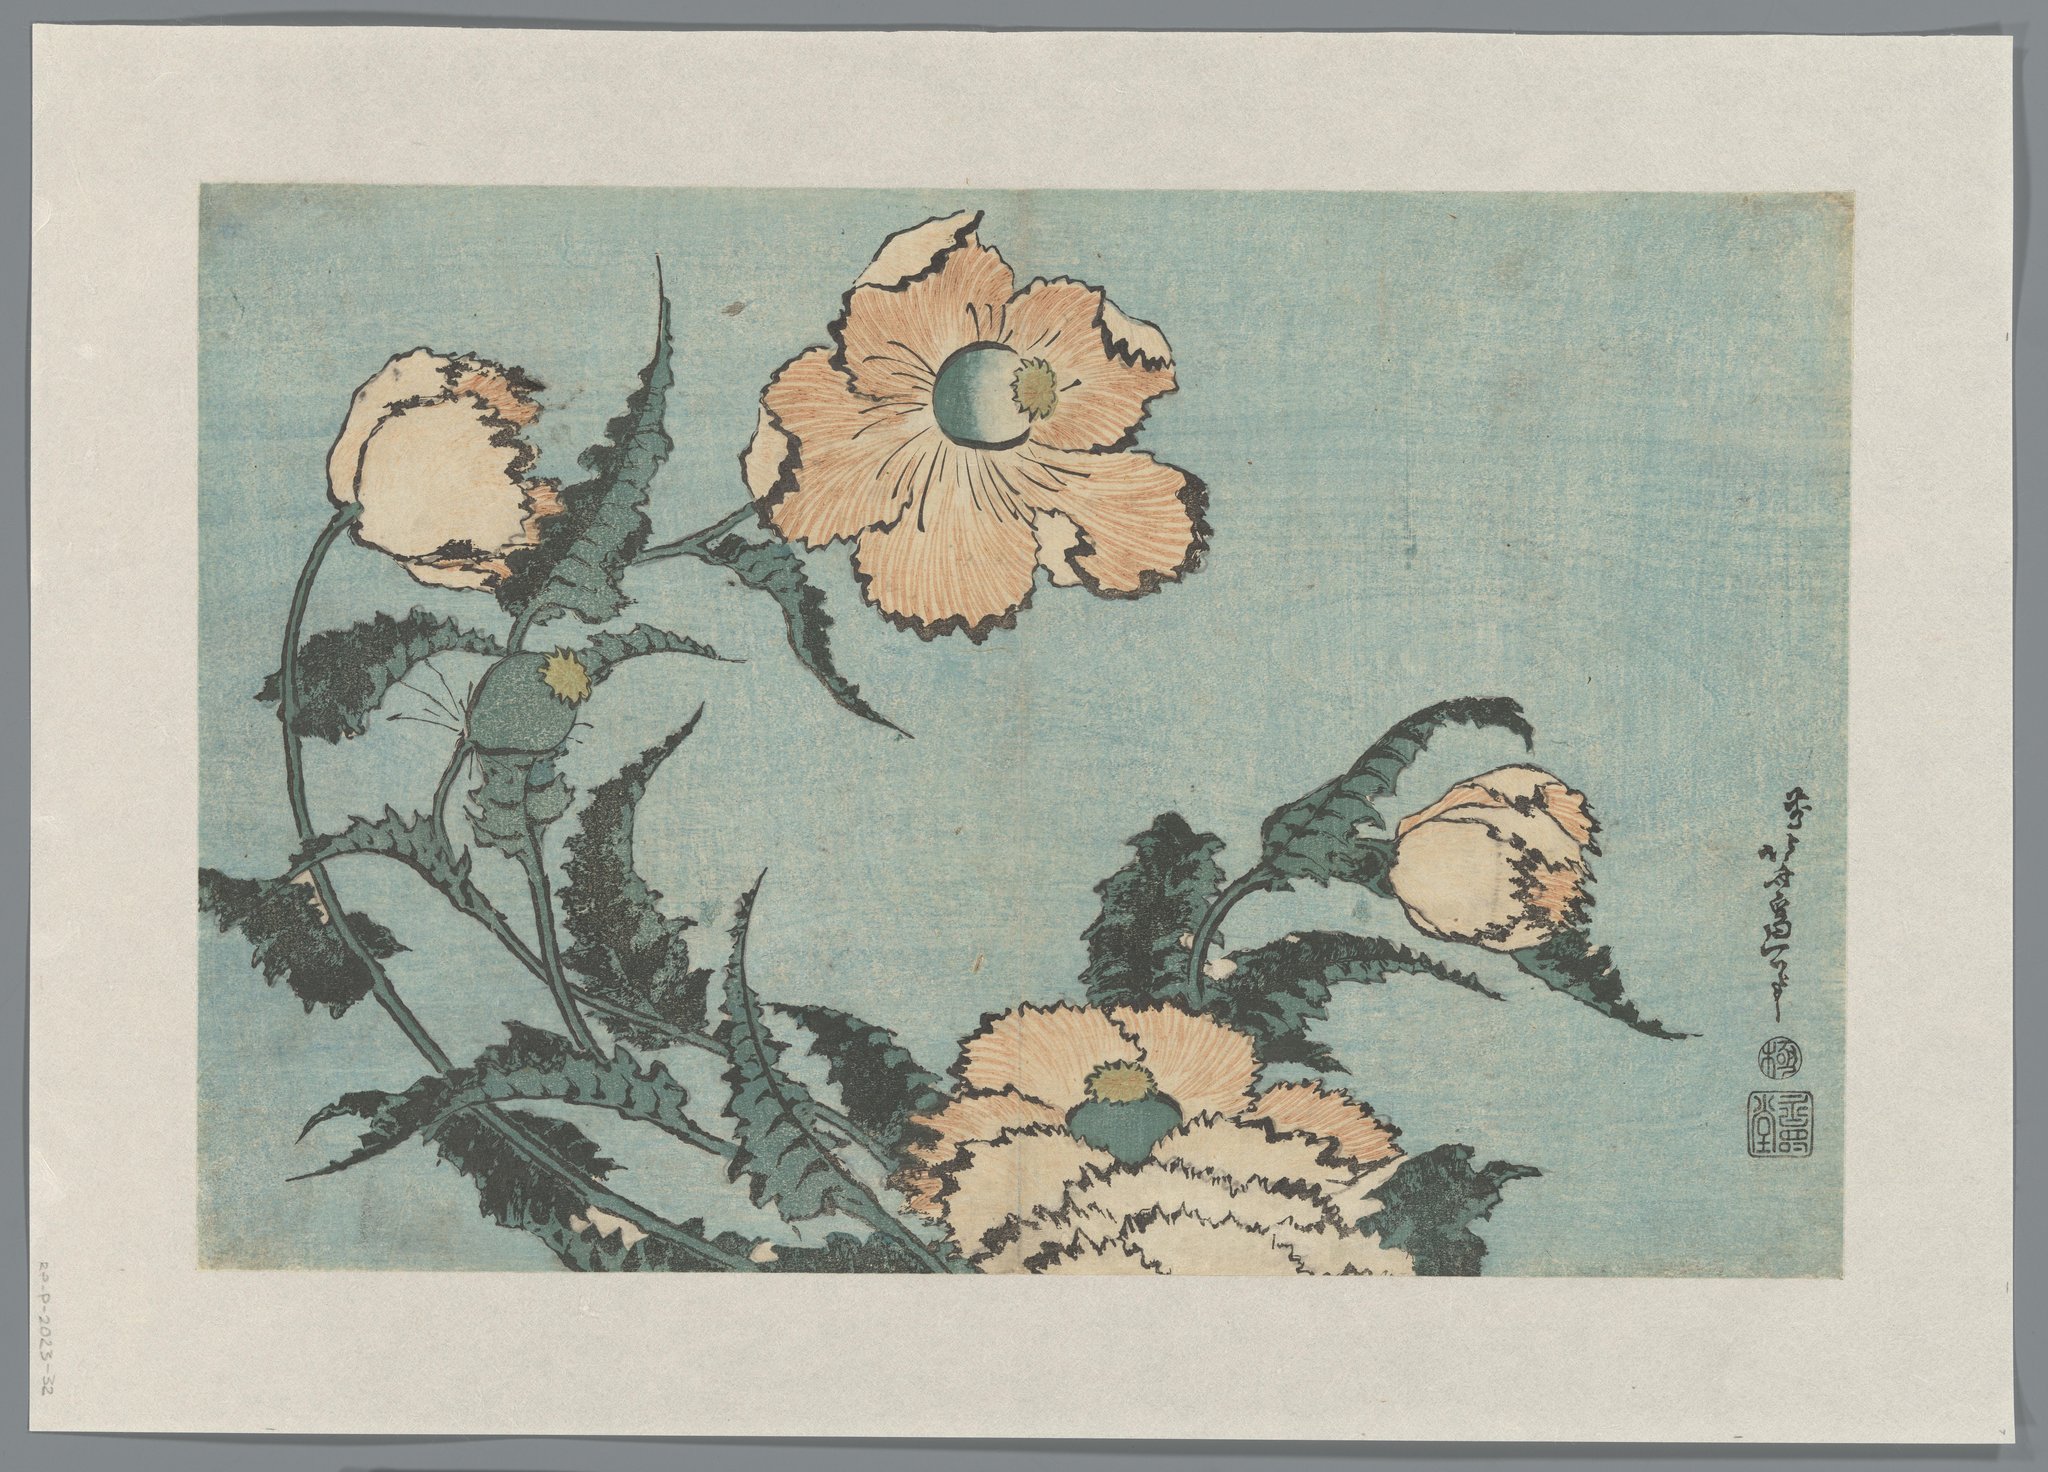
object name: print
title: Poppies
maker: katsushika hokusai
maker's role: draughtsman, print maker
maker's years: 1760-1849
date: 1832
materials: paper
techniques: woodcut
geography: japan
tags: flowers: poppy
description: Klaprozen in de wind tegen een lichtblauwe achtergrond.